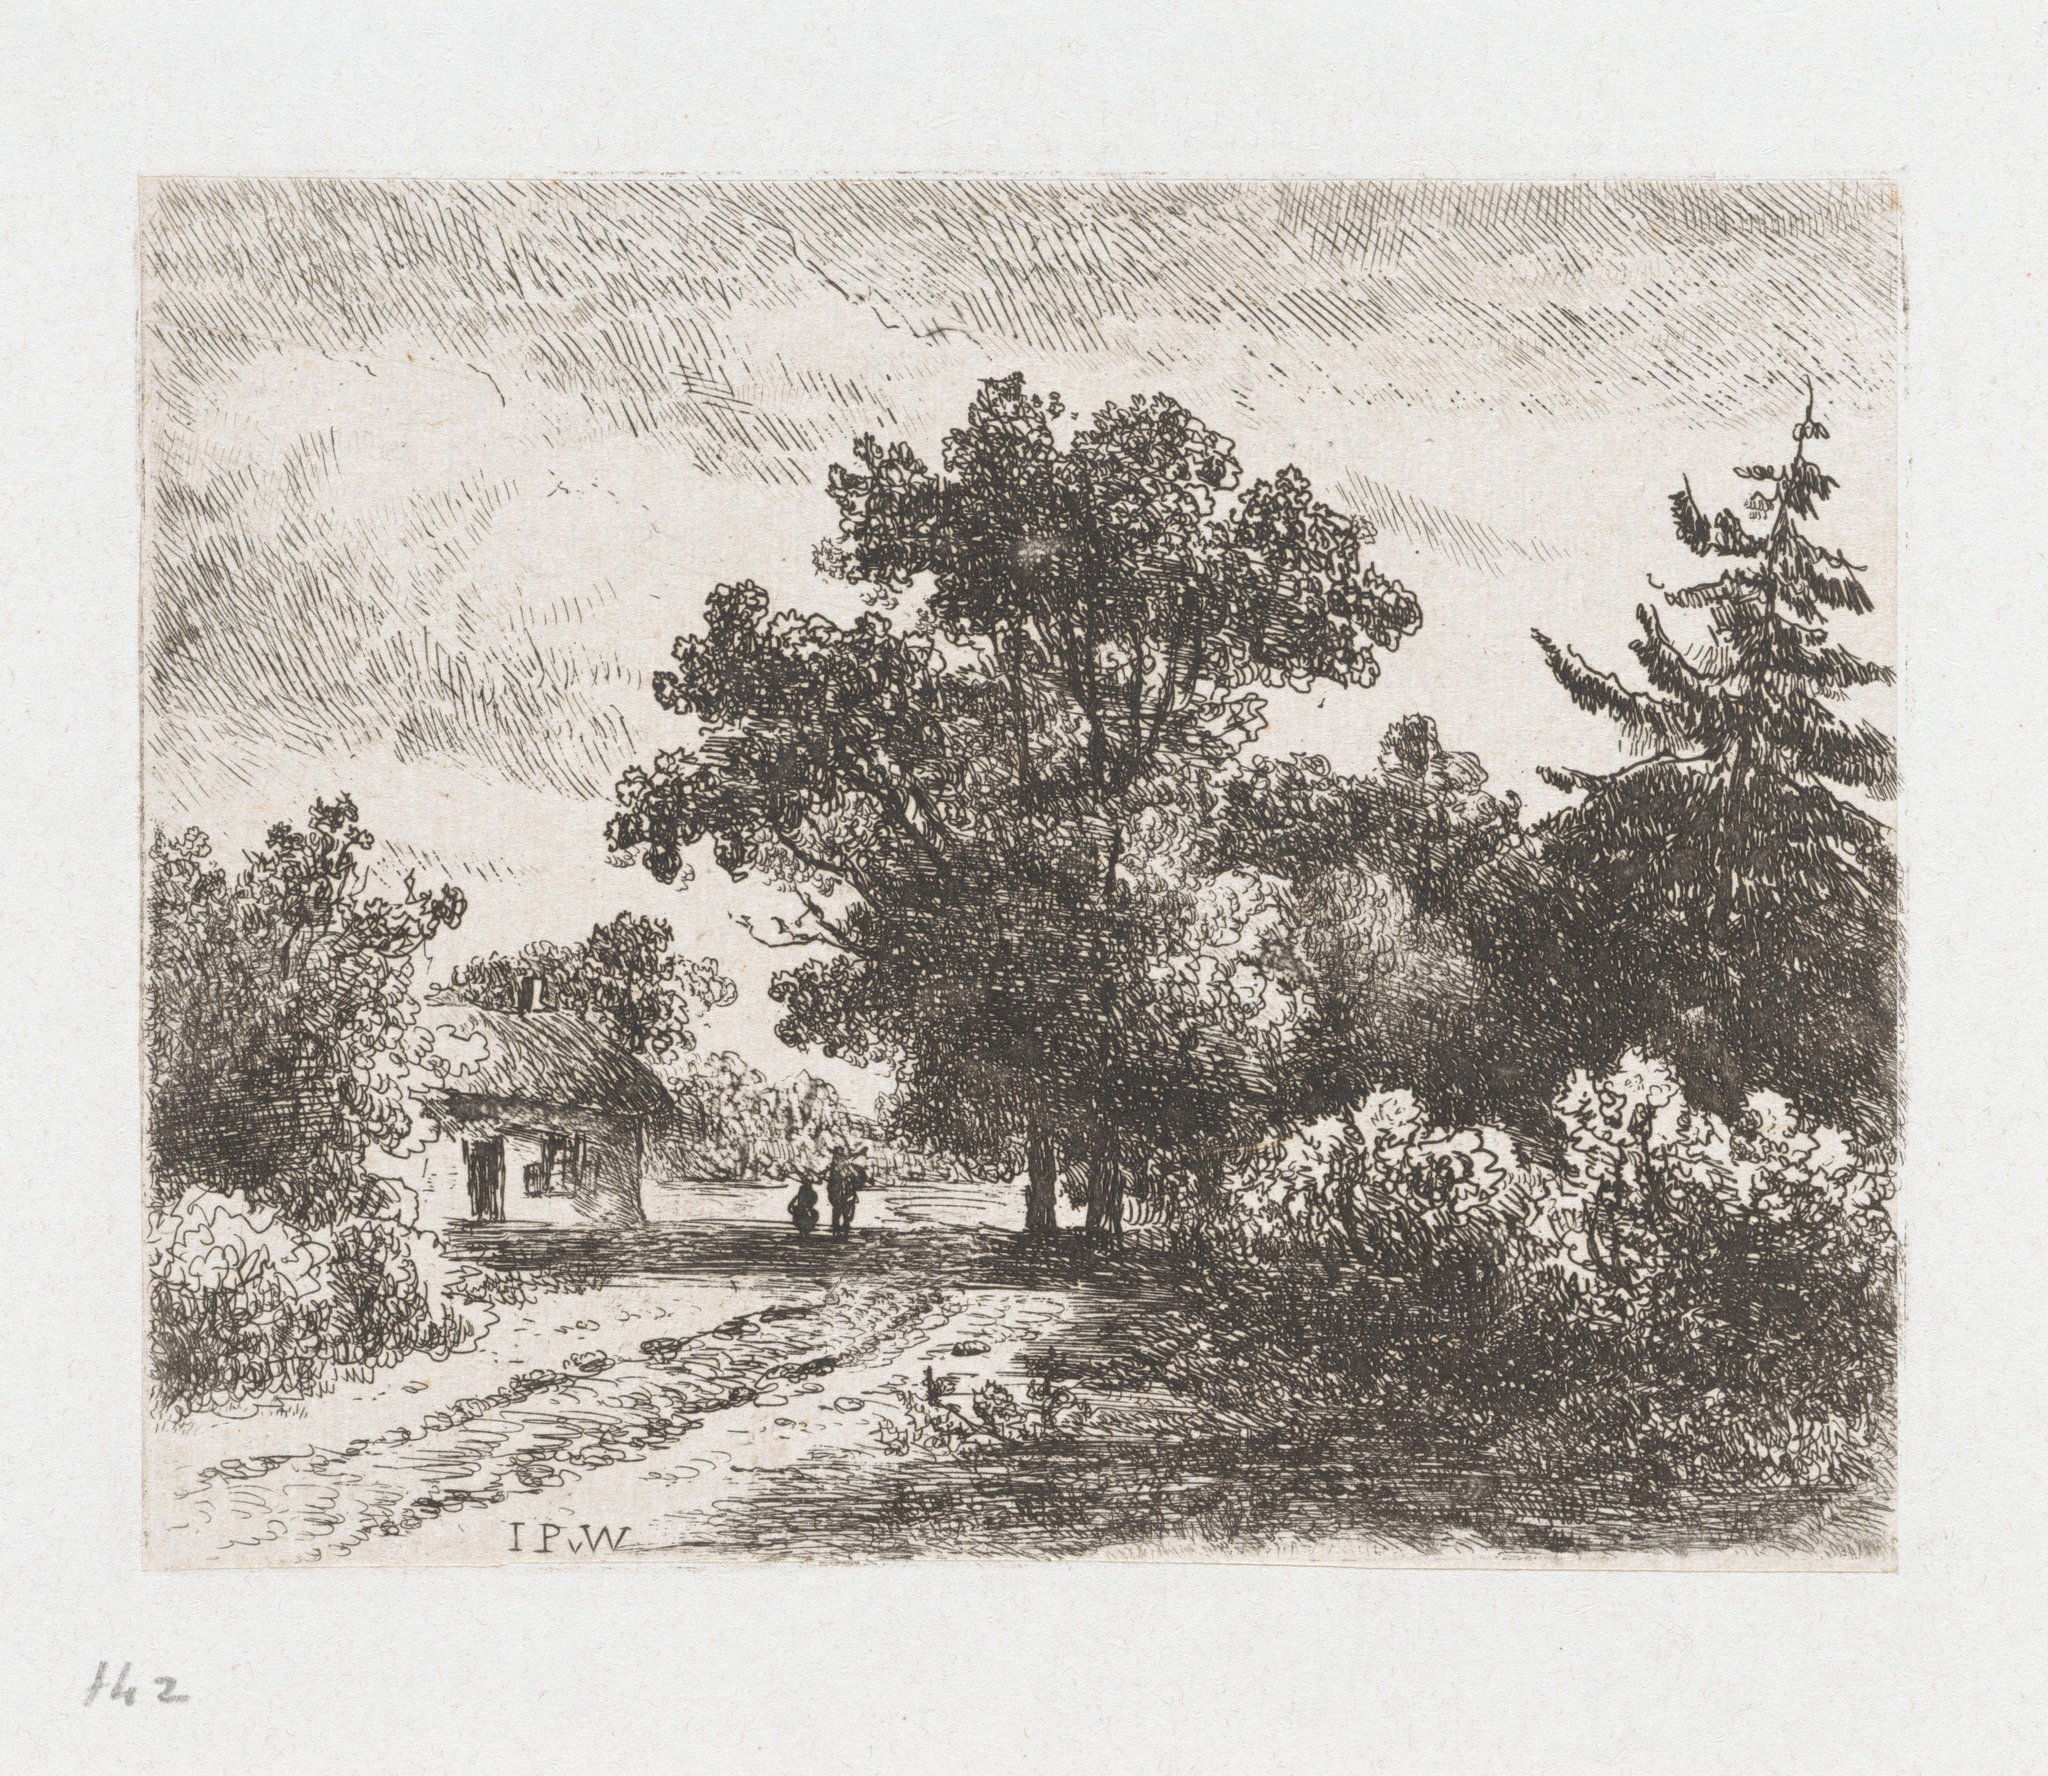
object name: print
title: Twee personen op een landweg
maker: johannes pieter van wisselingh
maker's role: draughtsman, painter, print maker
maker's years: 1812-1899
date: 1830-1878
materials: paper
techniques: etching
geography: netherlands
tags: rural housing, e.g. country-house, villa, cottage, road, path, groups of trees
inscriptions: collector's mark: Lugt 2228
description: Op een landweg lopen twee figuren langs een huis. Rechts een bomengroep.